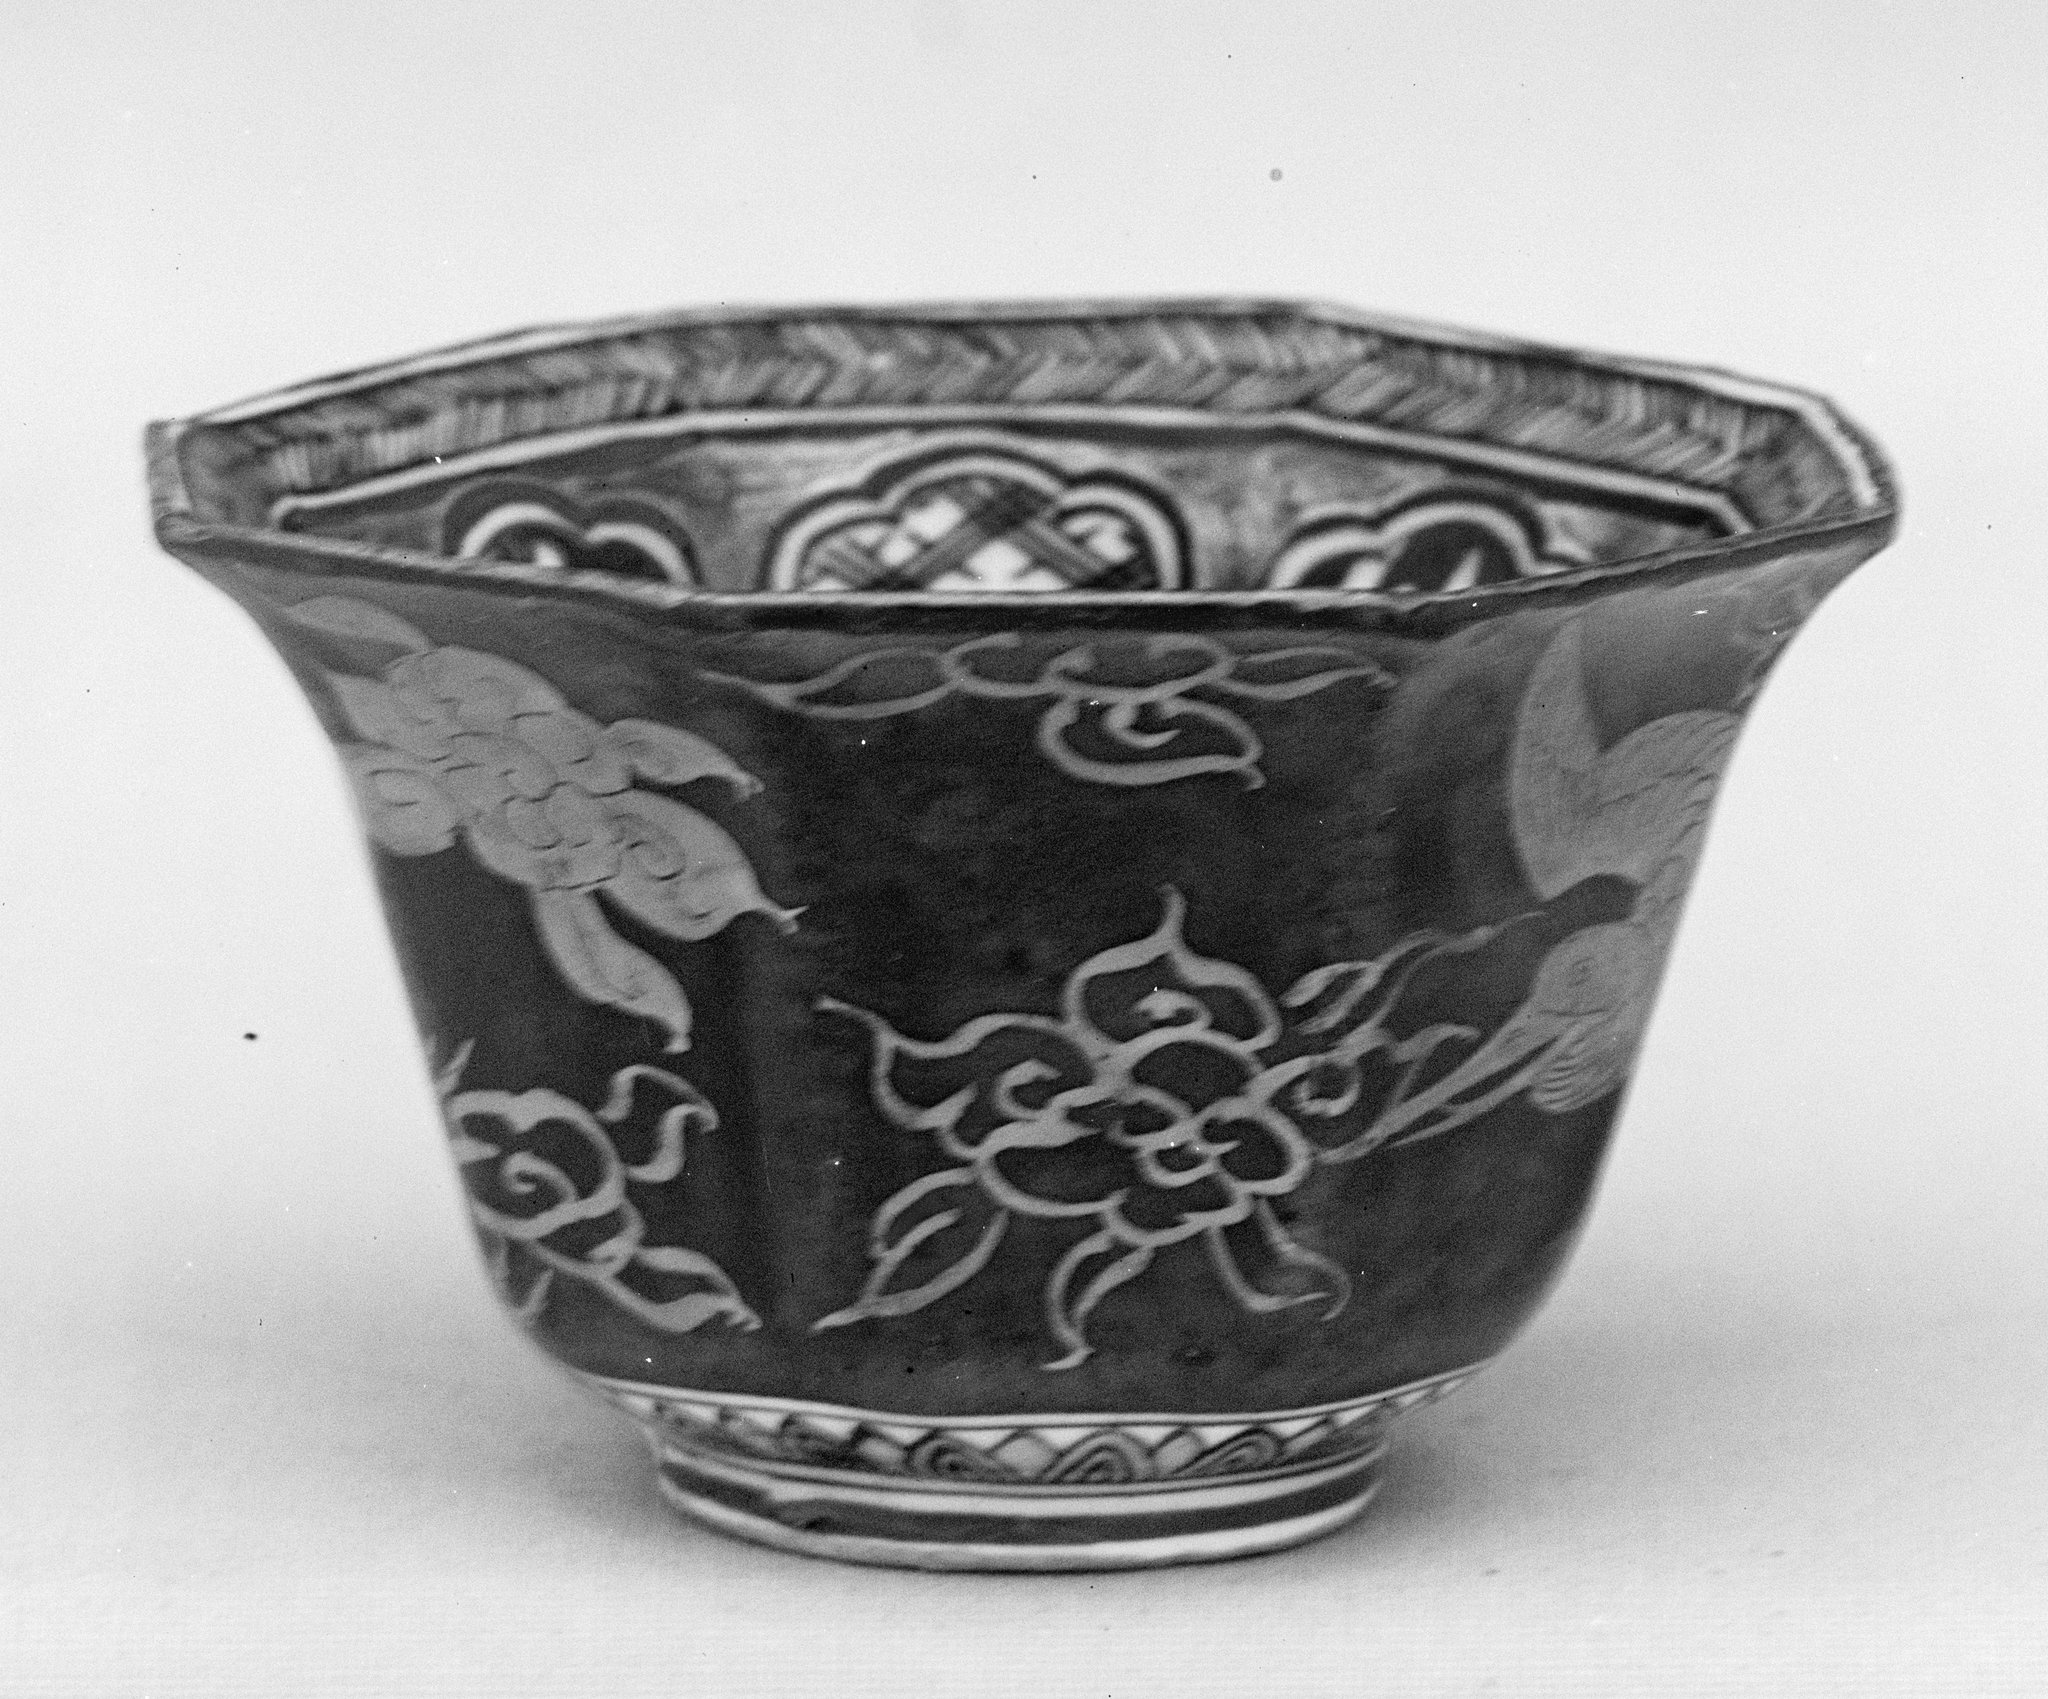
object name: cup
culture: japanese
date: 1801-1833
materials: gold, porcelain